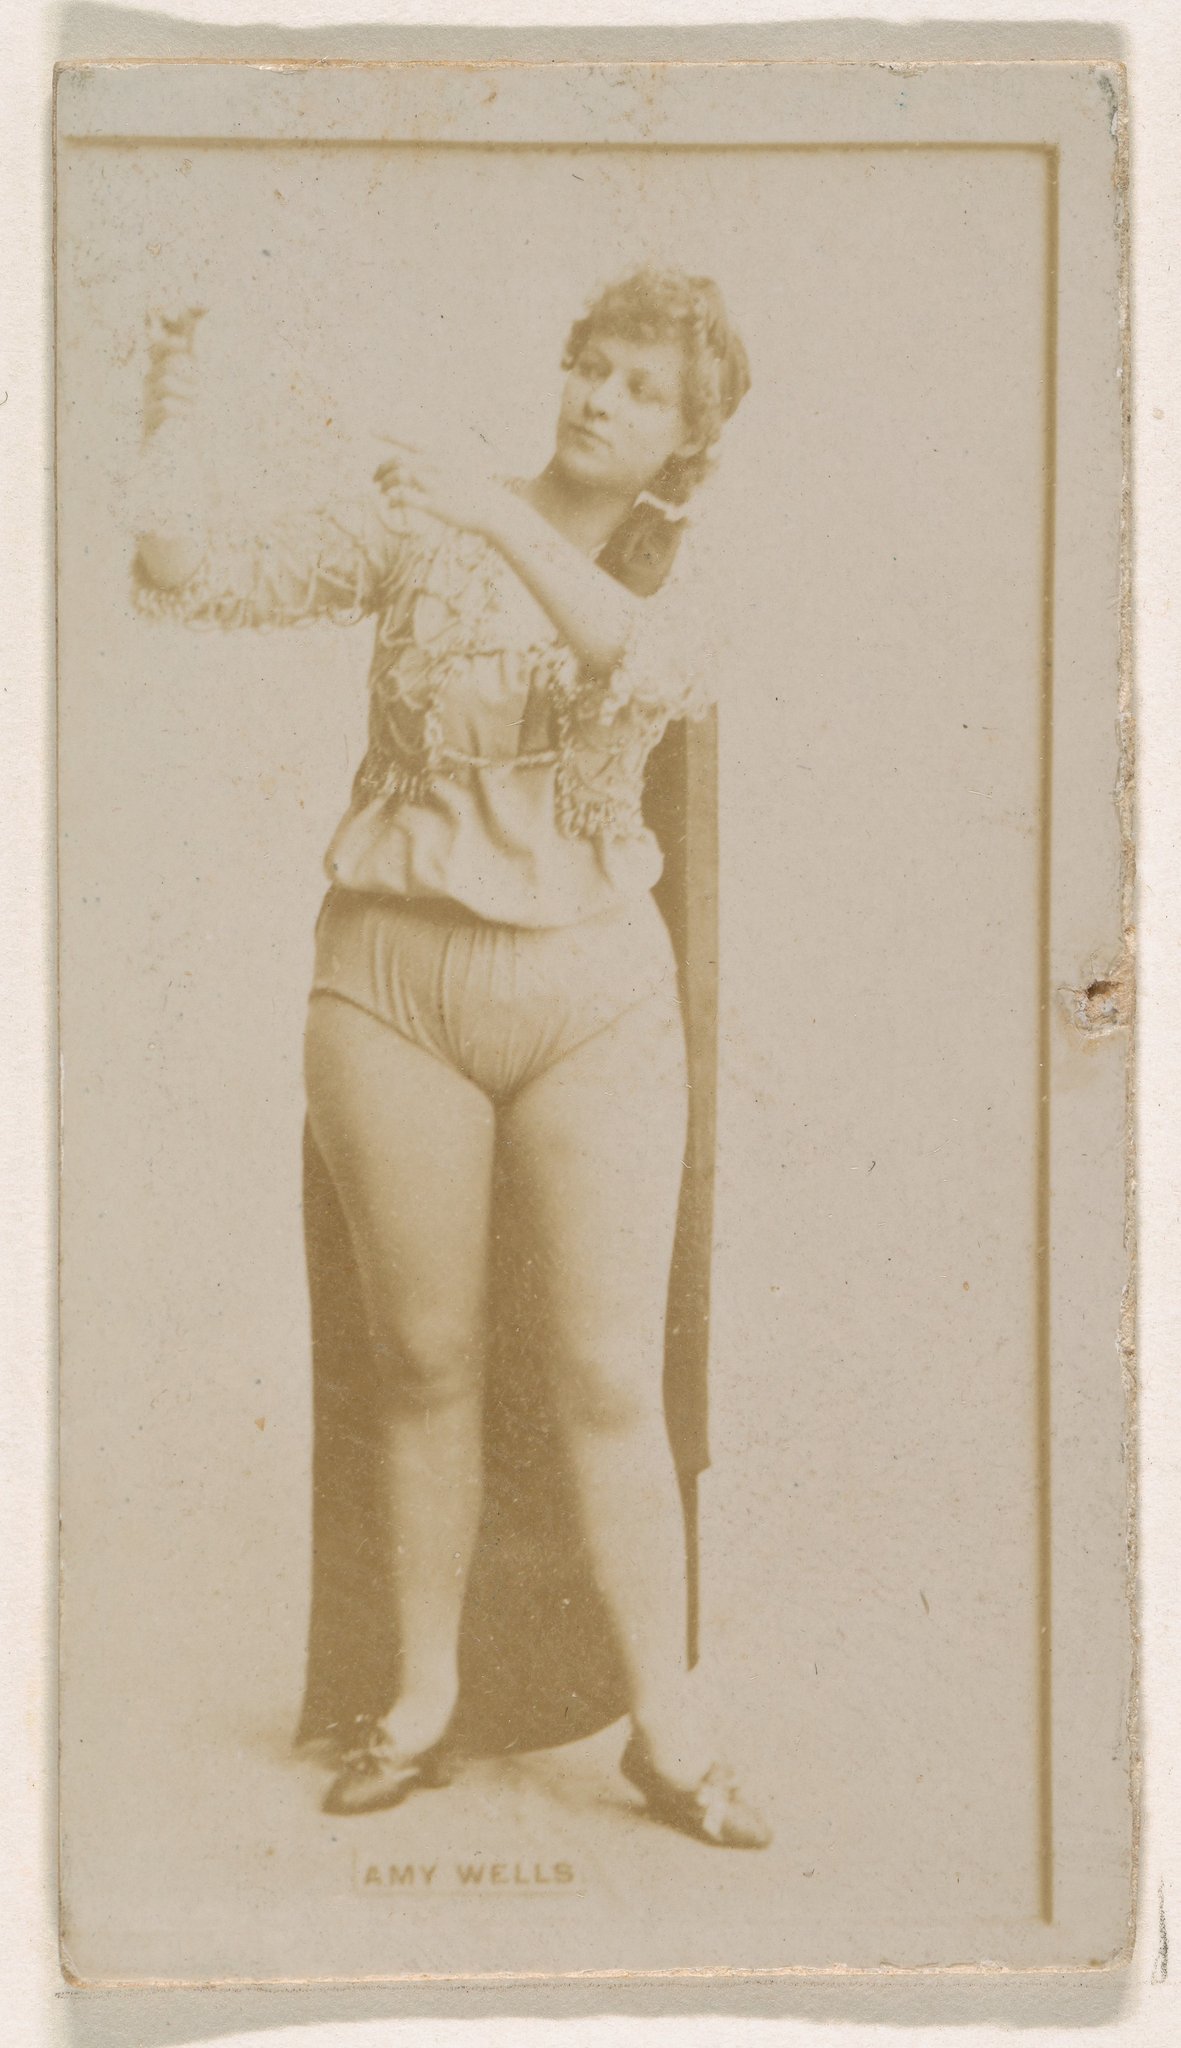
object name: photograph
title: Amy Wells, from the Actresses series (N245) issued by Kinney Brothers to promote Sweet Caporal Cigarettes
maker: kinney brothers tobacco company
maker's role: publisher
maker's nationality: american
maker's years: 1869-2011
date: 1890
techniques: albumen silver print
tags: portraits,women,actresses